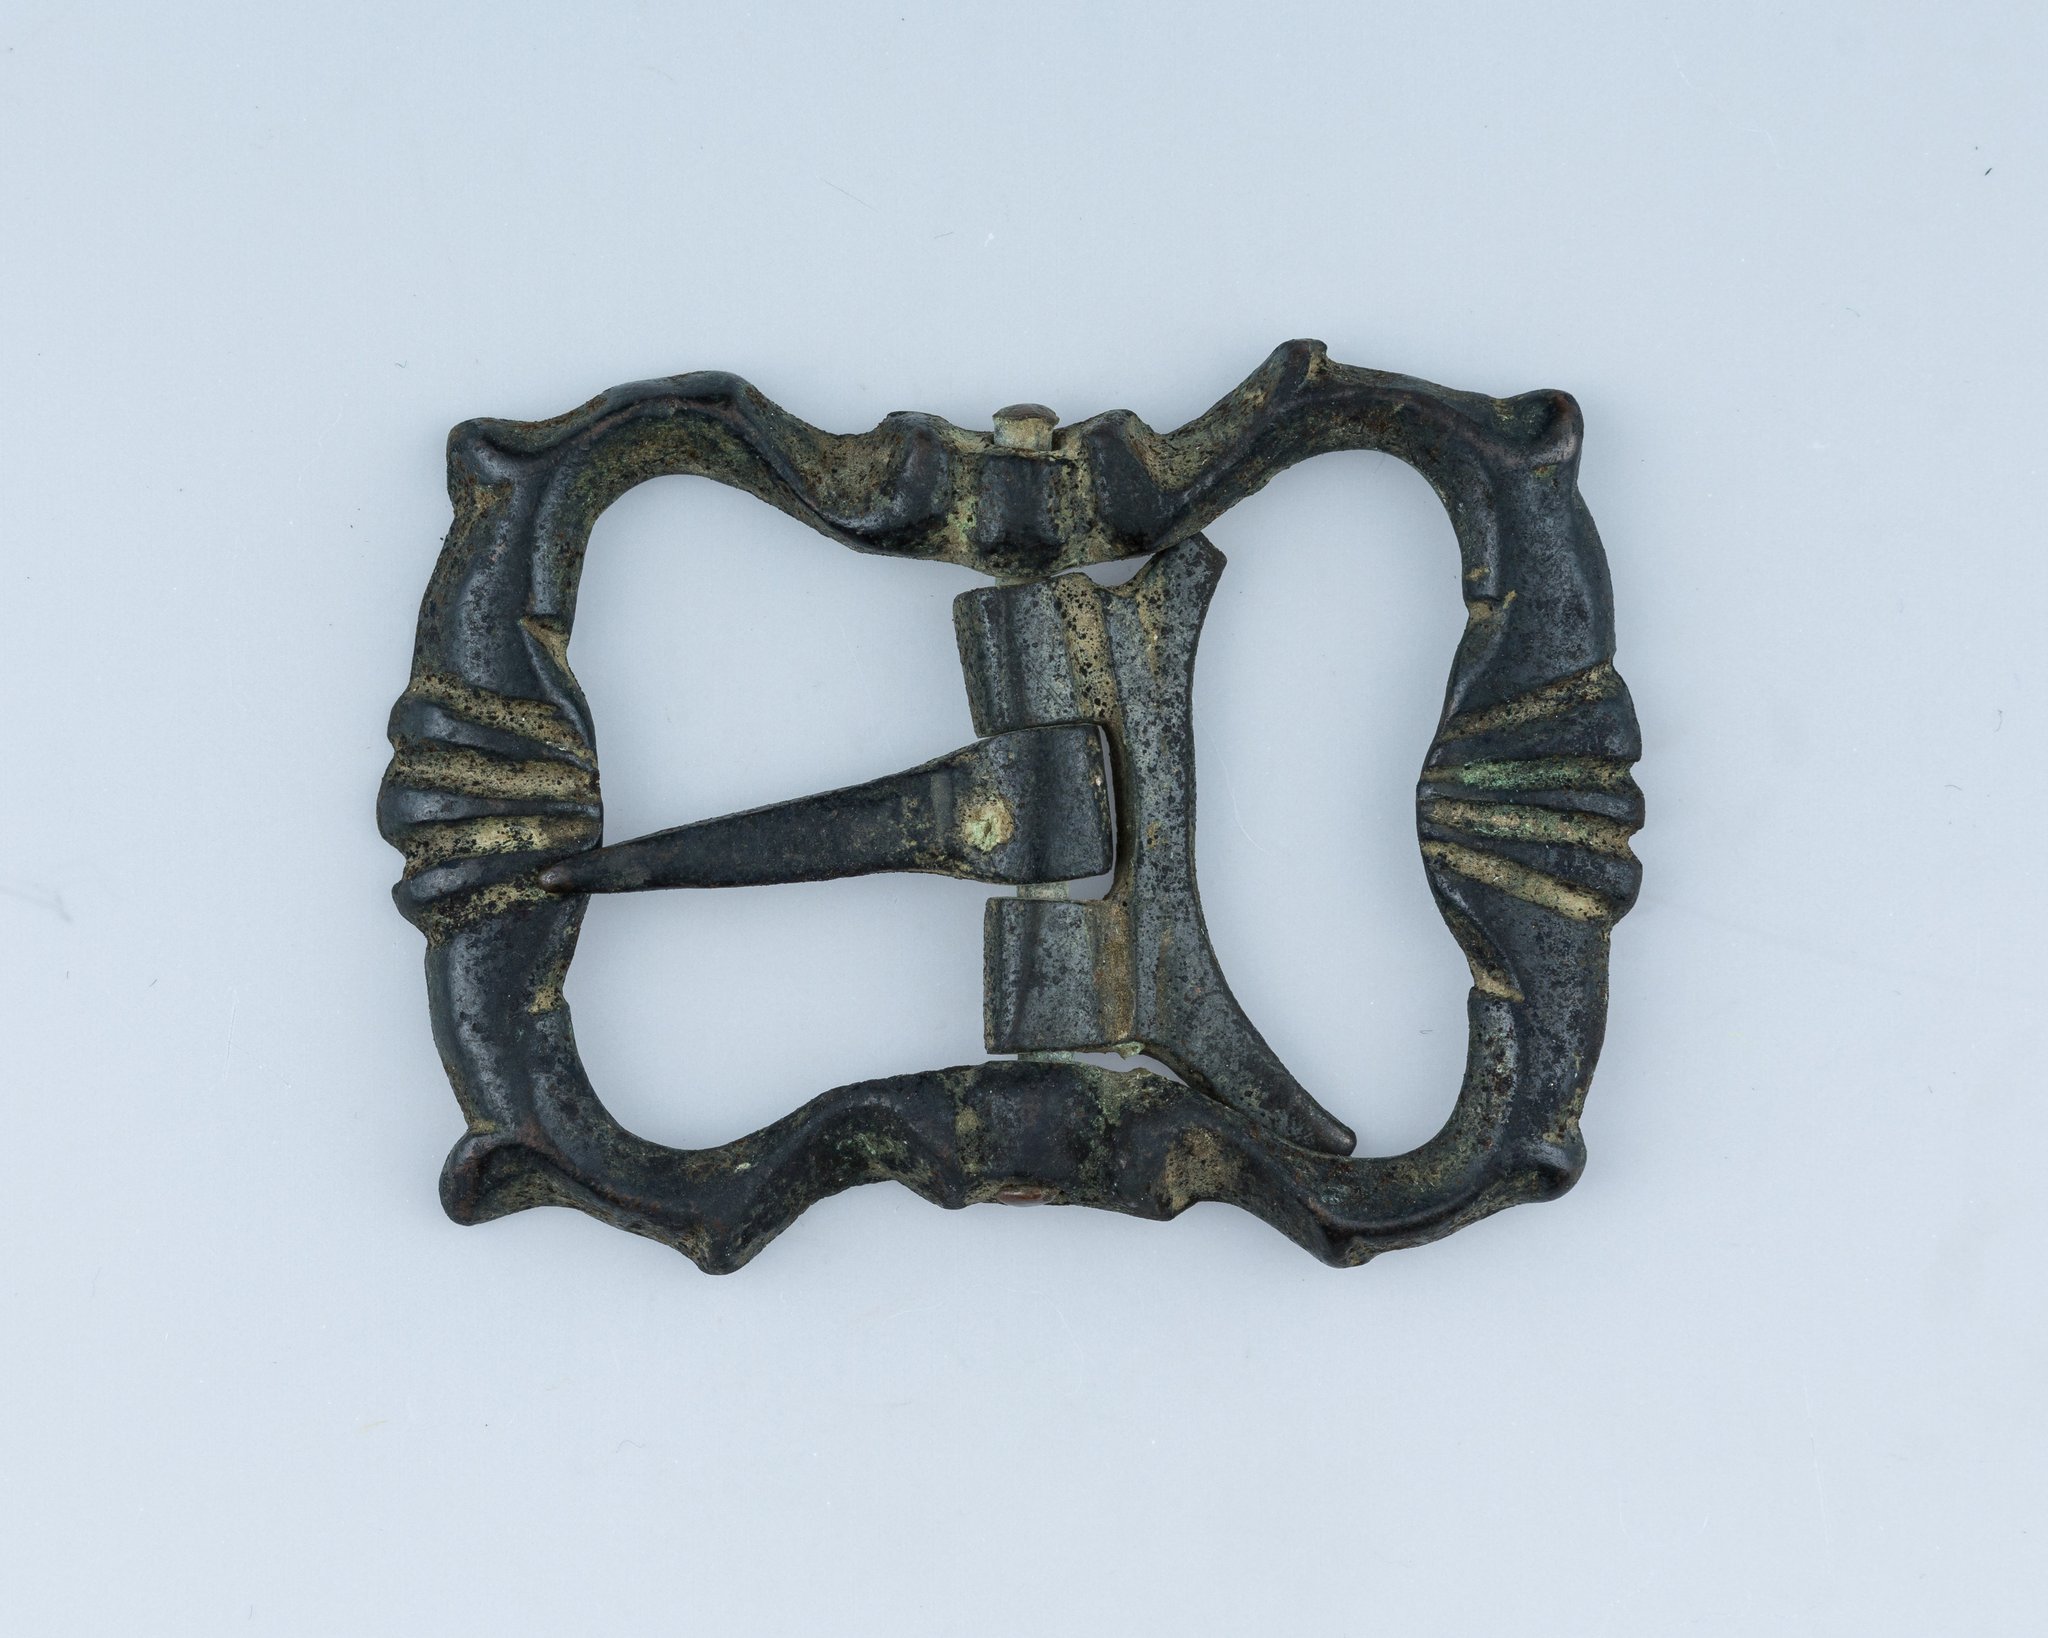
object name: buckle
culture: french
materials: bronze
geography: france